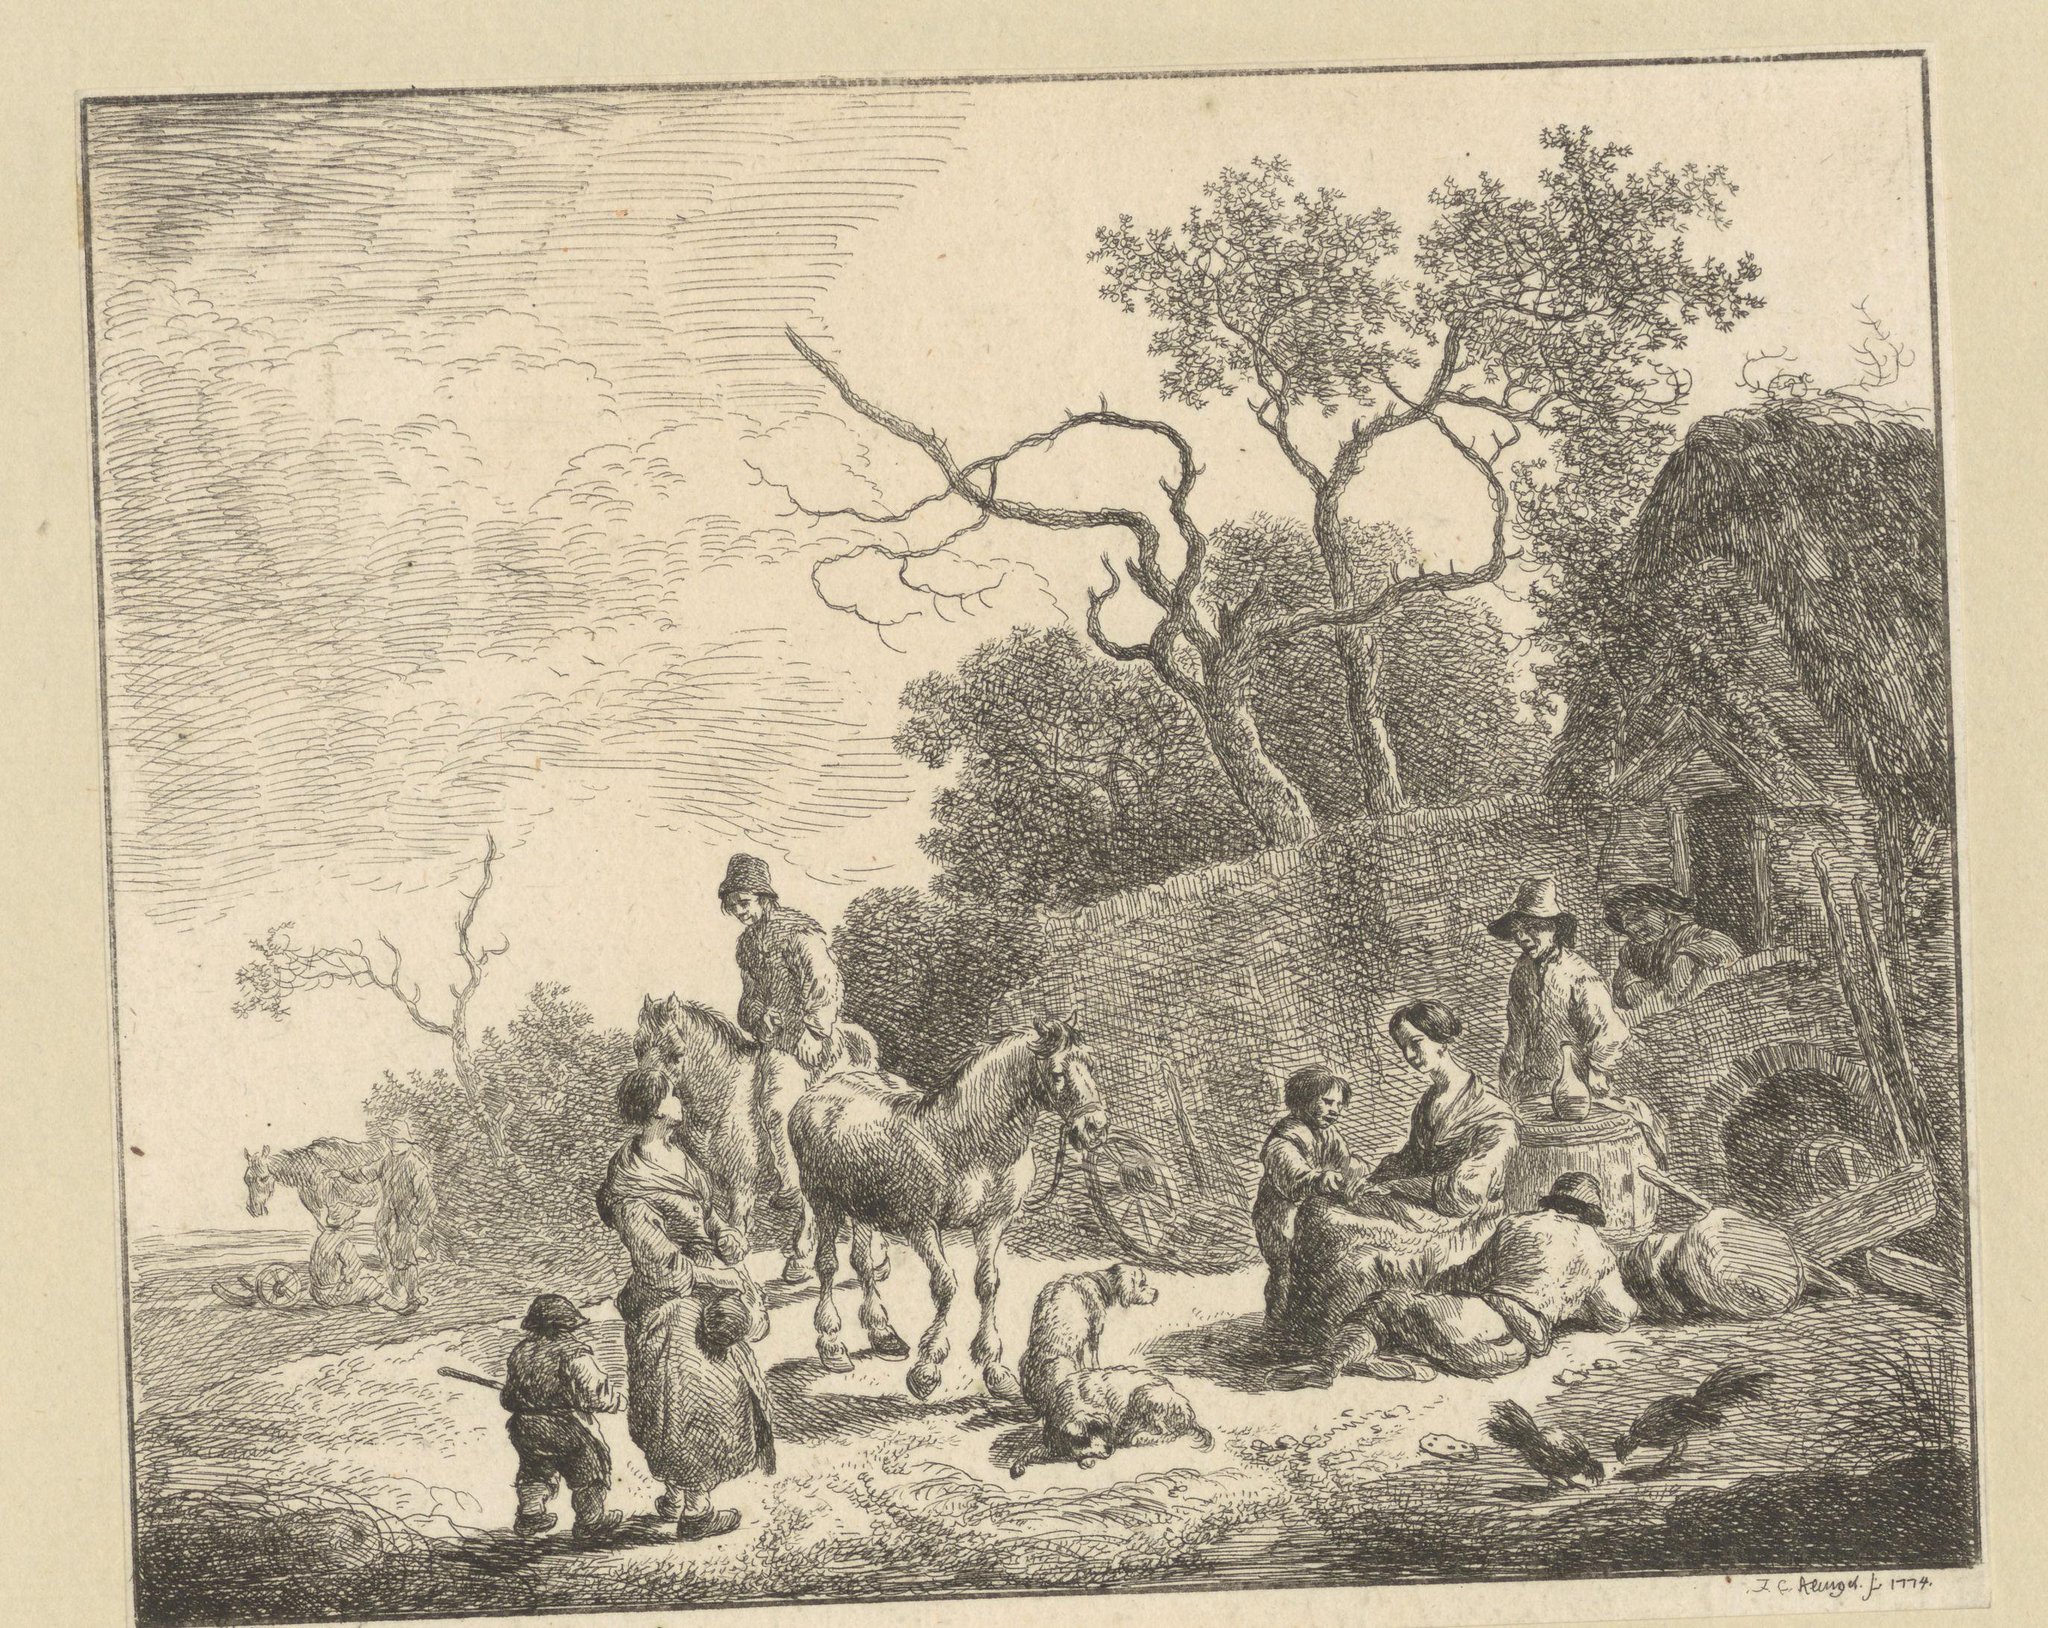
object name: print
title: Landschap met rustende mensen en man te paard voor een huis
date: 1774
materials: paper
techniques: etching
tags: riding a horse, ass, or mule; rider, horseman, (traveller) resting in the open air, cottage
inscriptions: collector's mark: Lugt 240